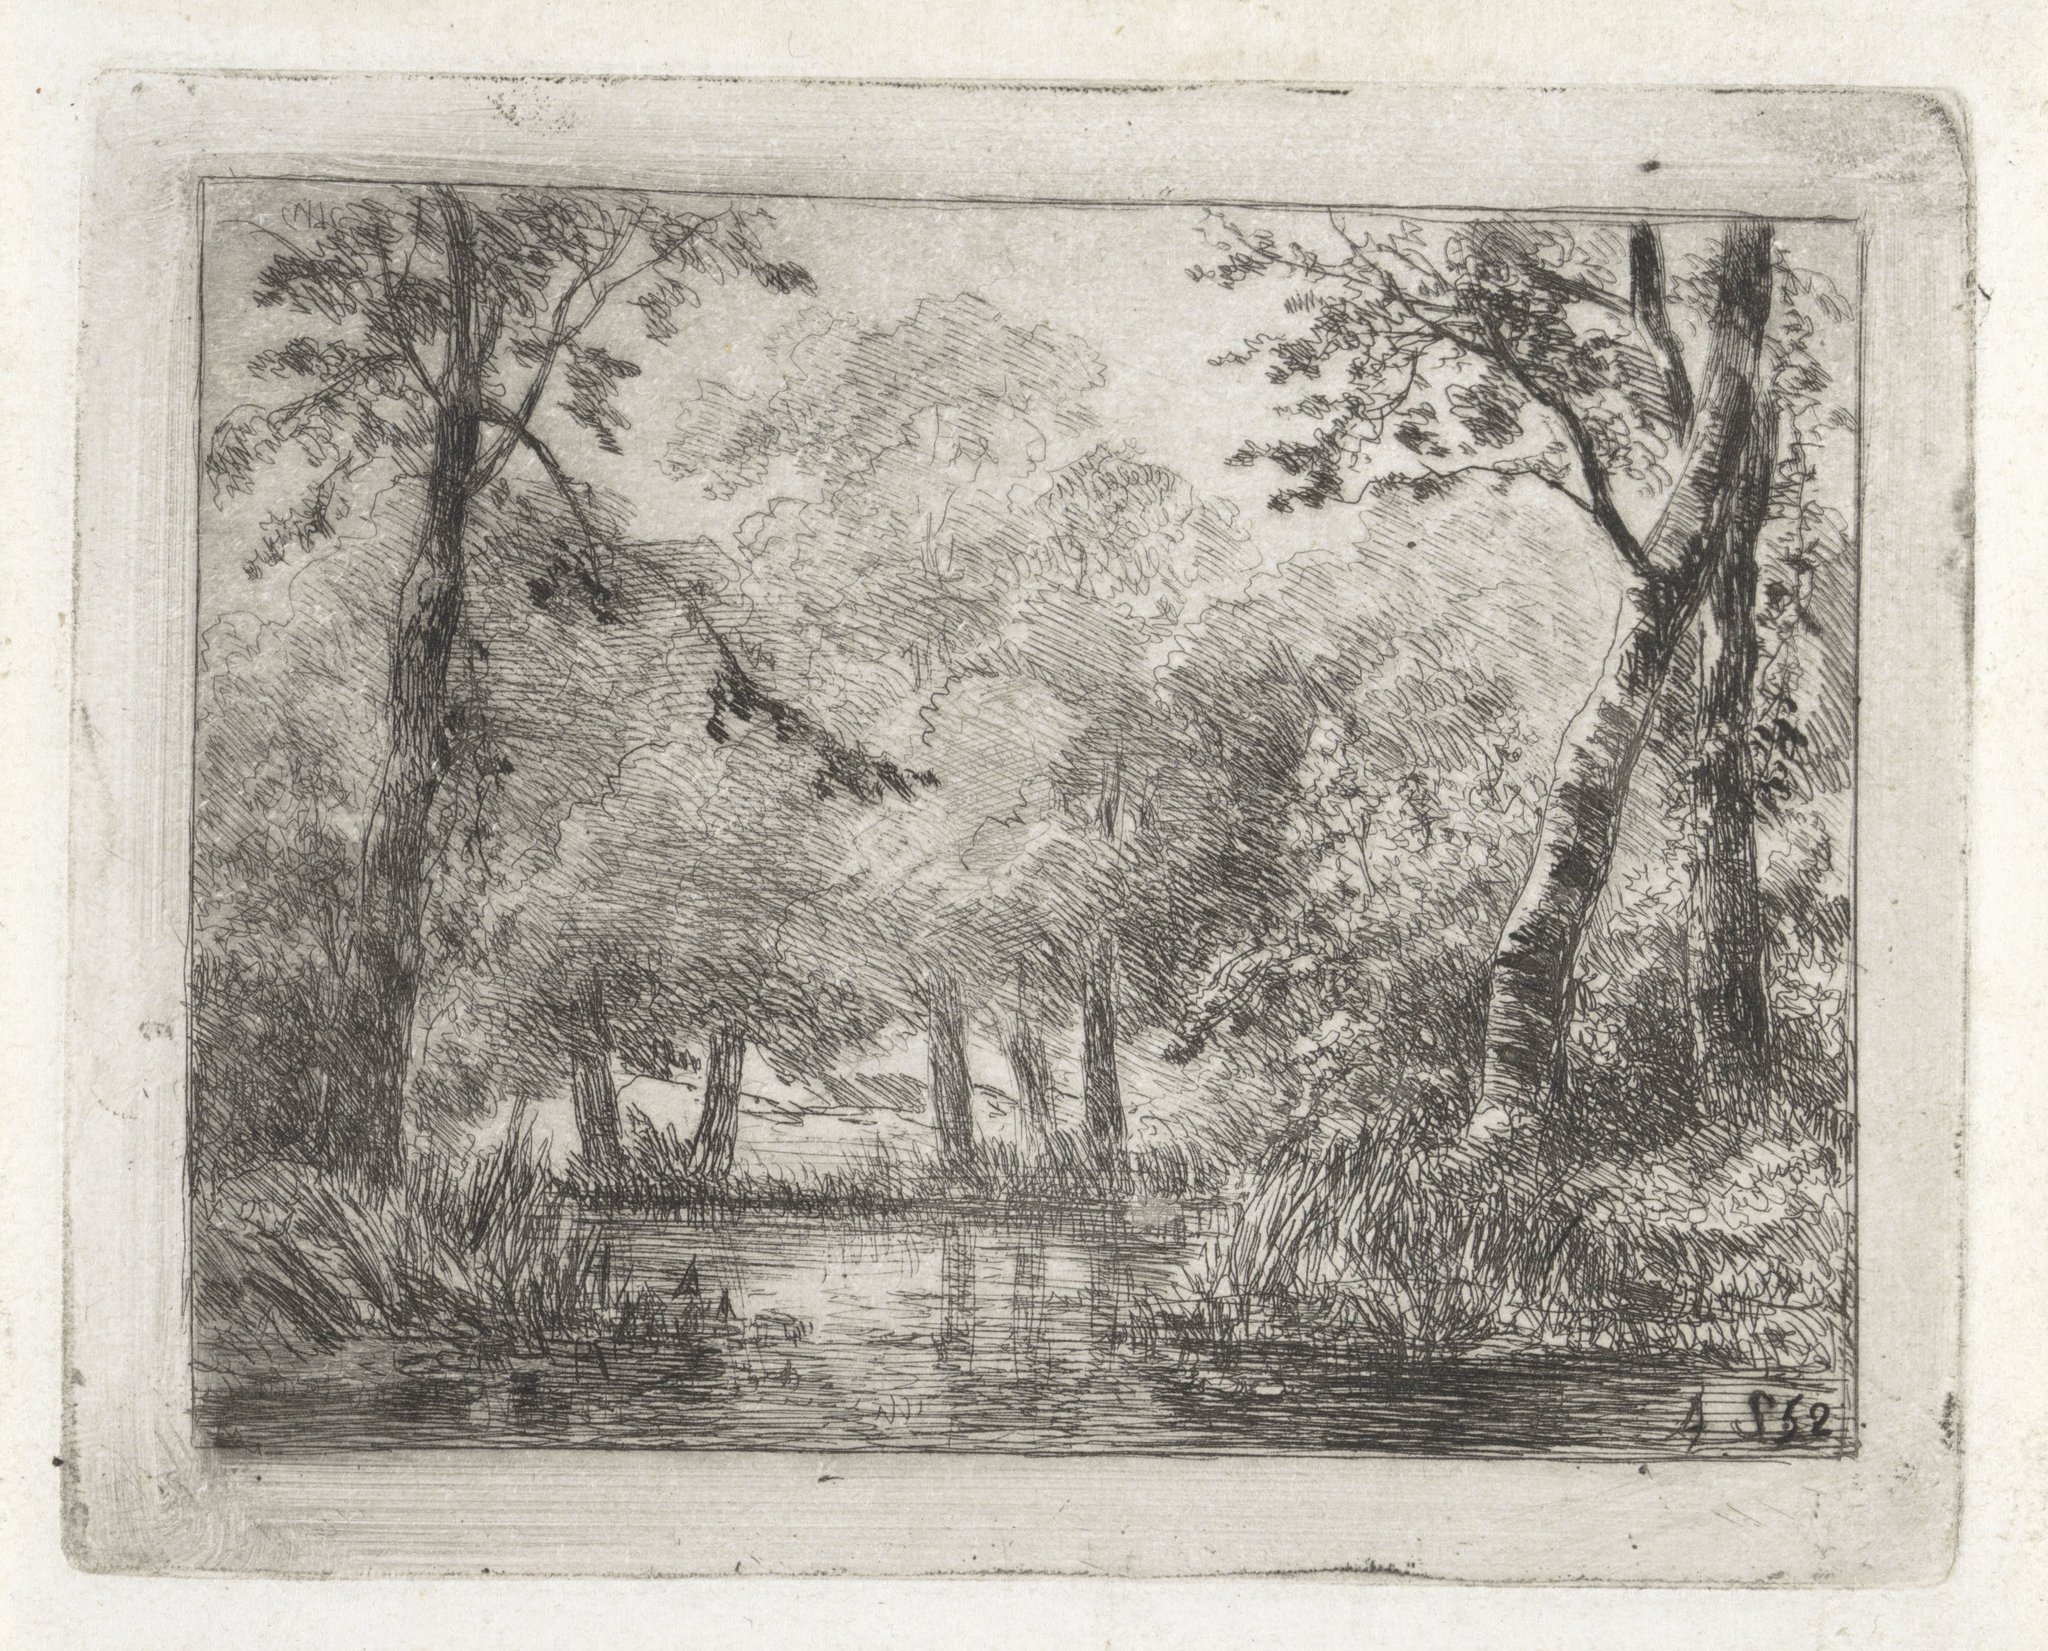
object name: print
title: Bosgezicht met vijver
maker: andreas schelfhout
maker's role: draughtsman, painter, print maker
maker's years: 1787-1870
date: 1852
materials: paper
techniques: etching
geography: the hague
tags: forest, wood, pond, pool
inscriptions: collector's mark: Lugt 2228